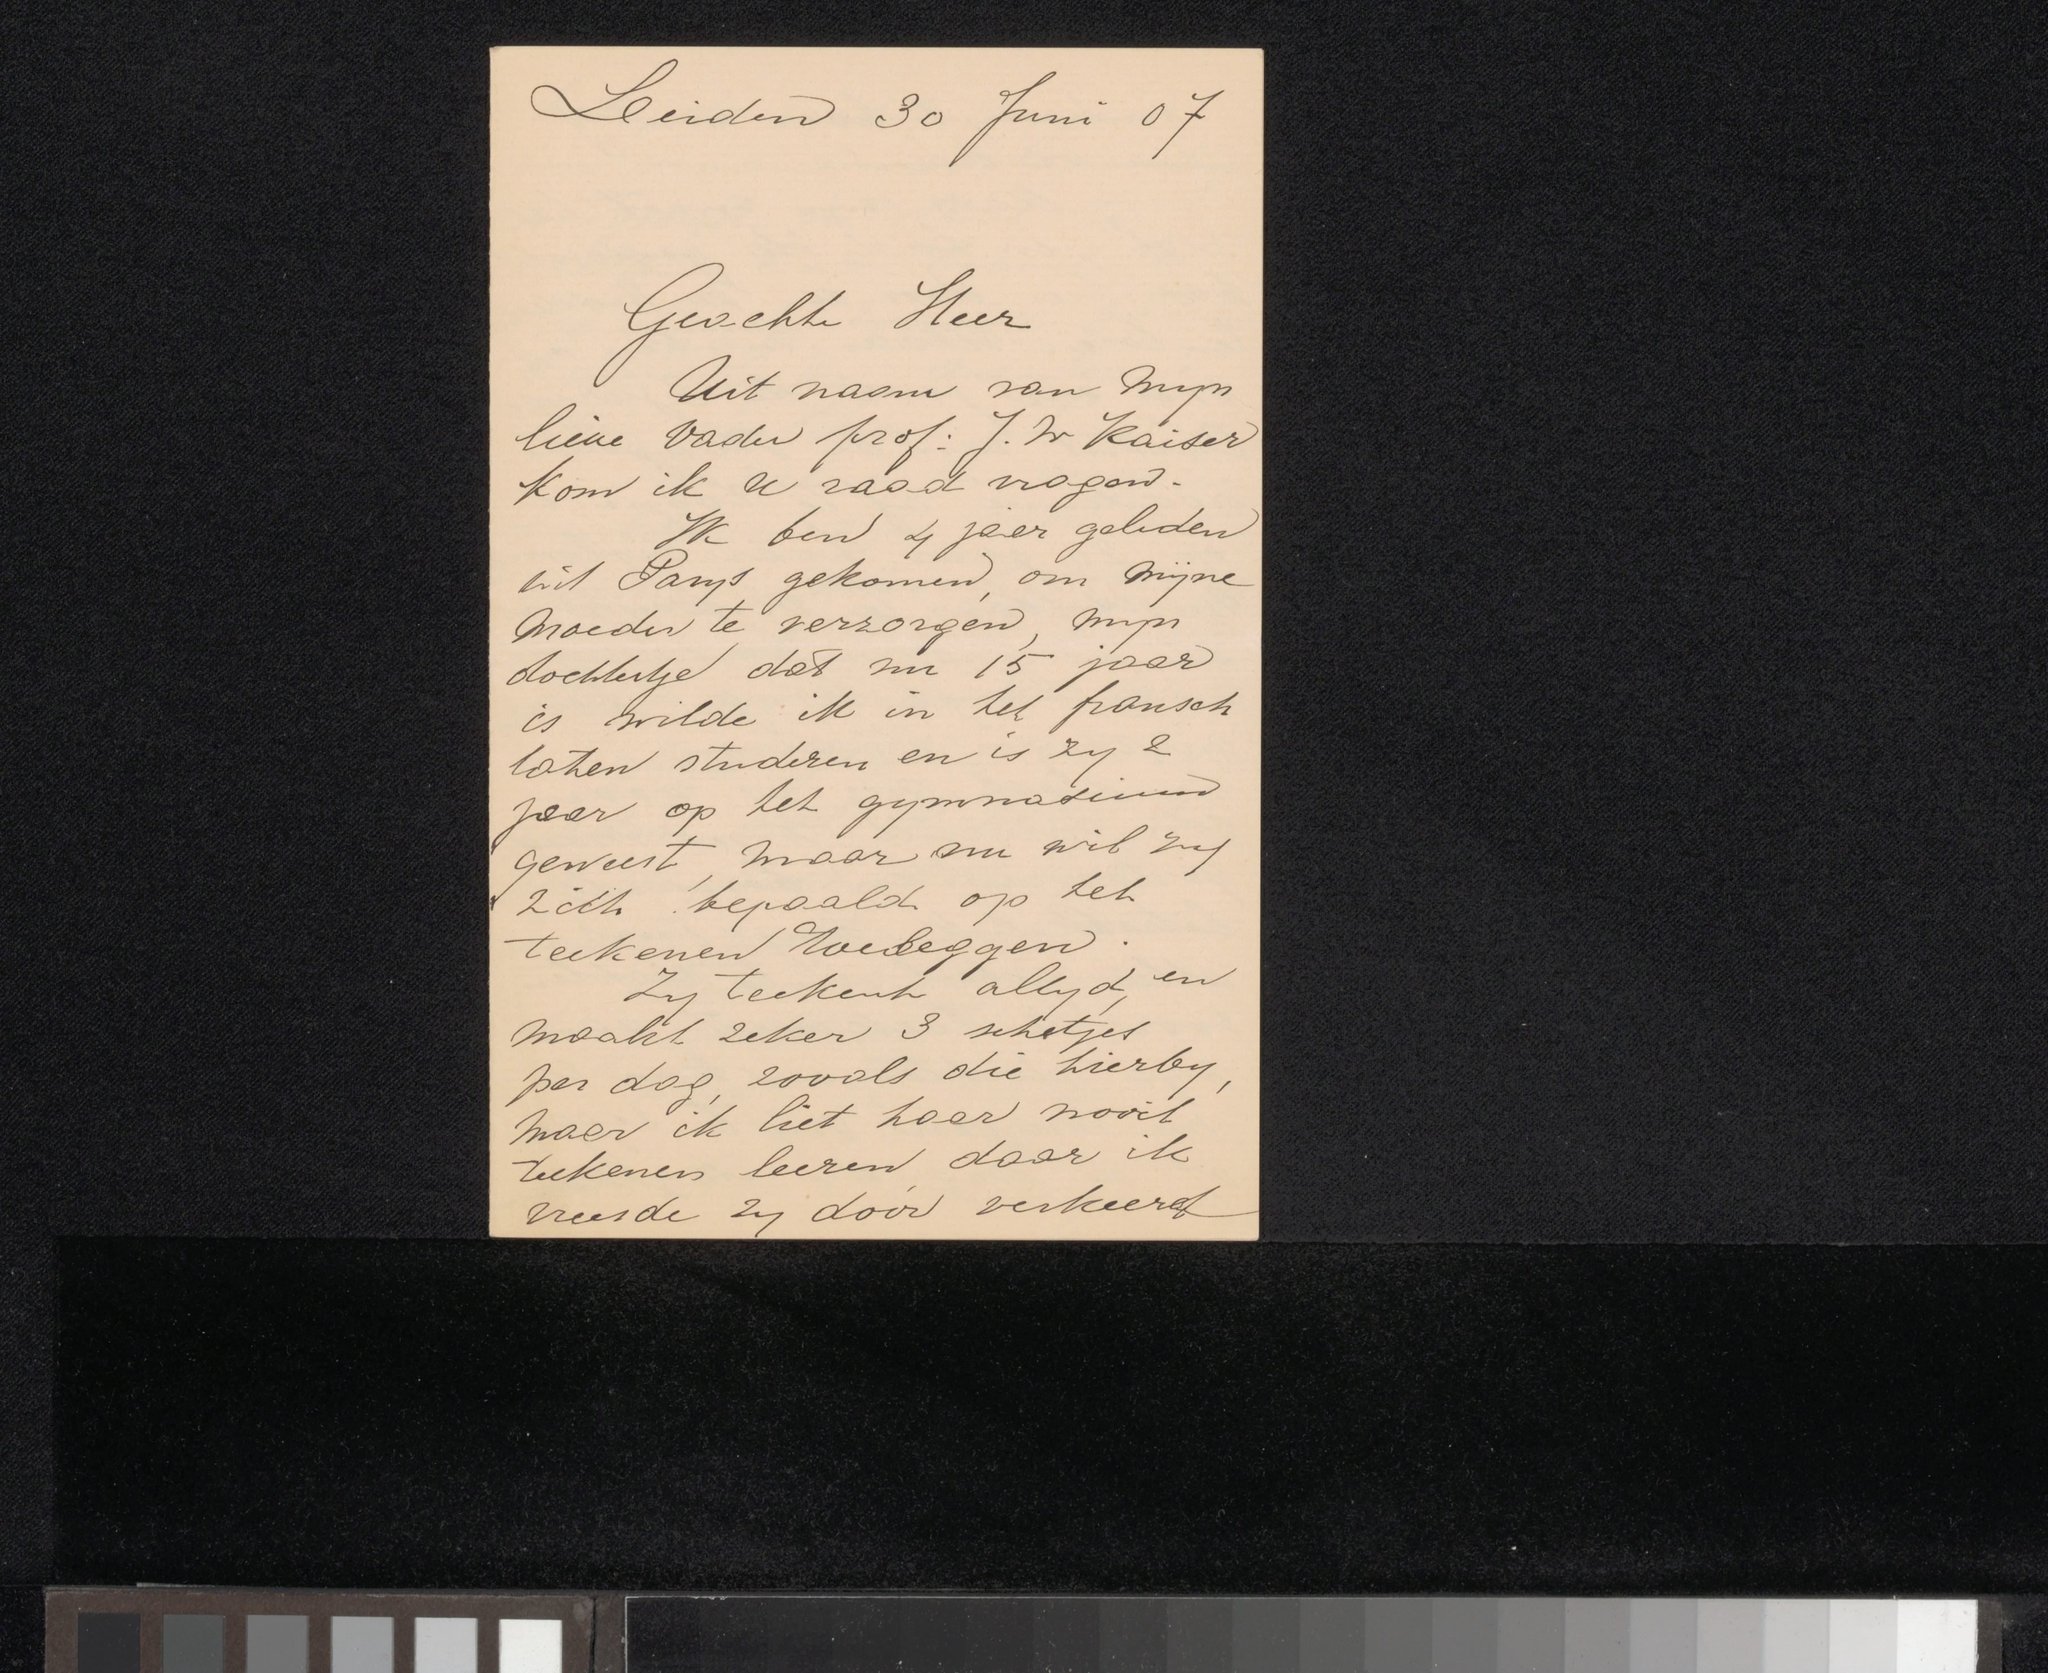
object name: letter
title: Brief aan August Allebé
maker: mevrouw ibels-kaiser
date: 1907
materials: ink, paper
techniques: pen, writing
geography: leiden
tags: august allebé, louise ibels, leiden, print maker, draughtsman, johann wilhelm kaiser (i), drawing, family life, education, tuition of the artist (in general), paris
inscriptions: watermark